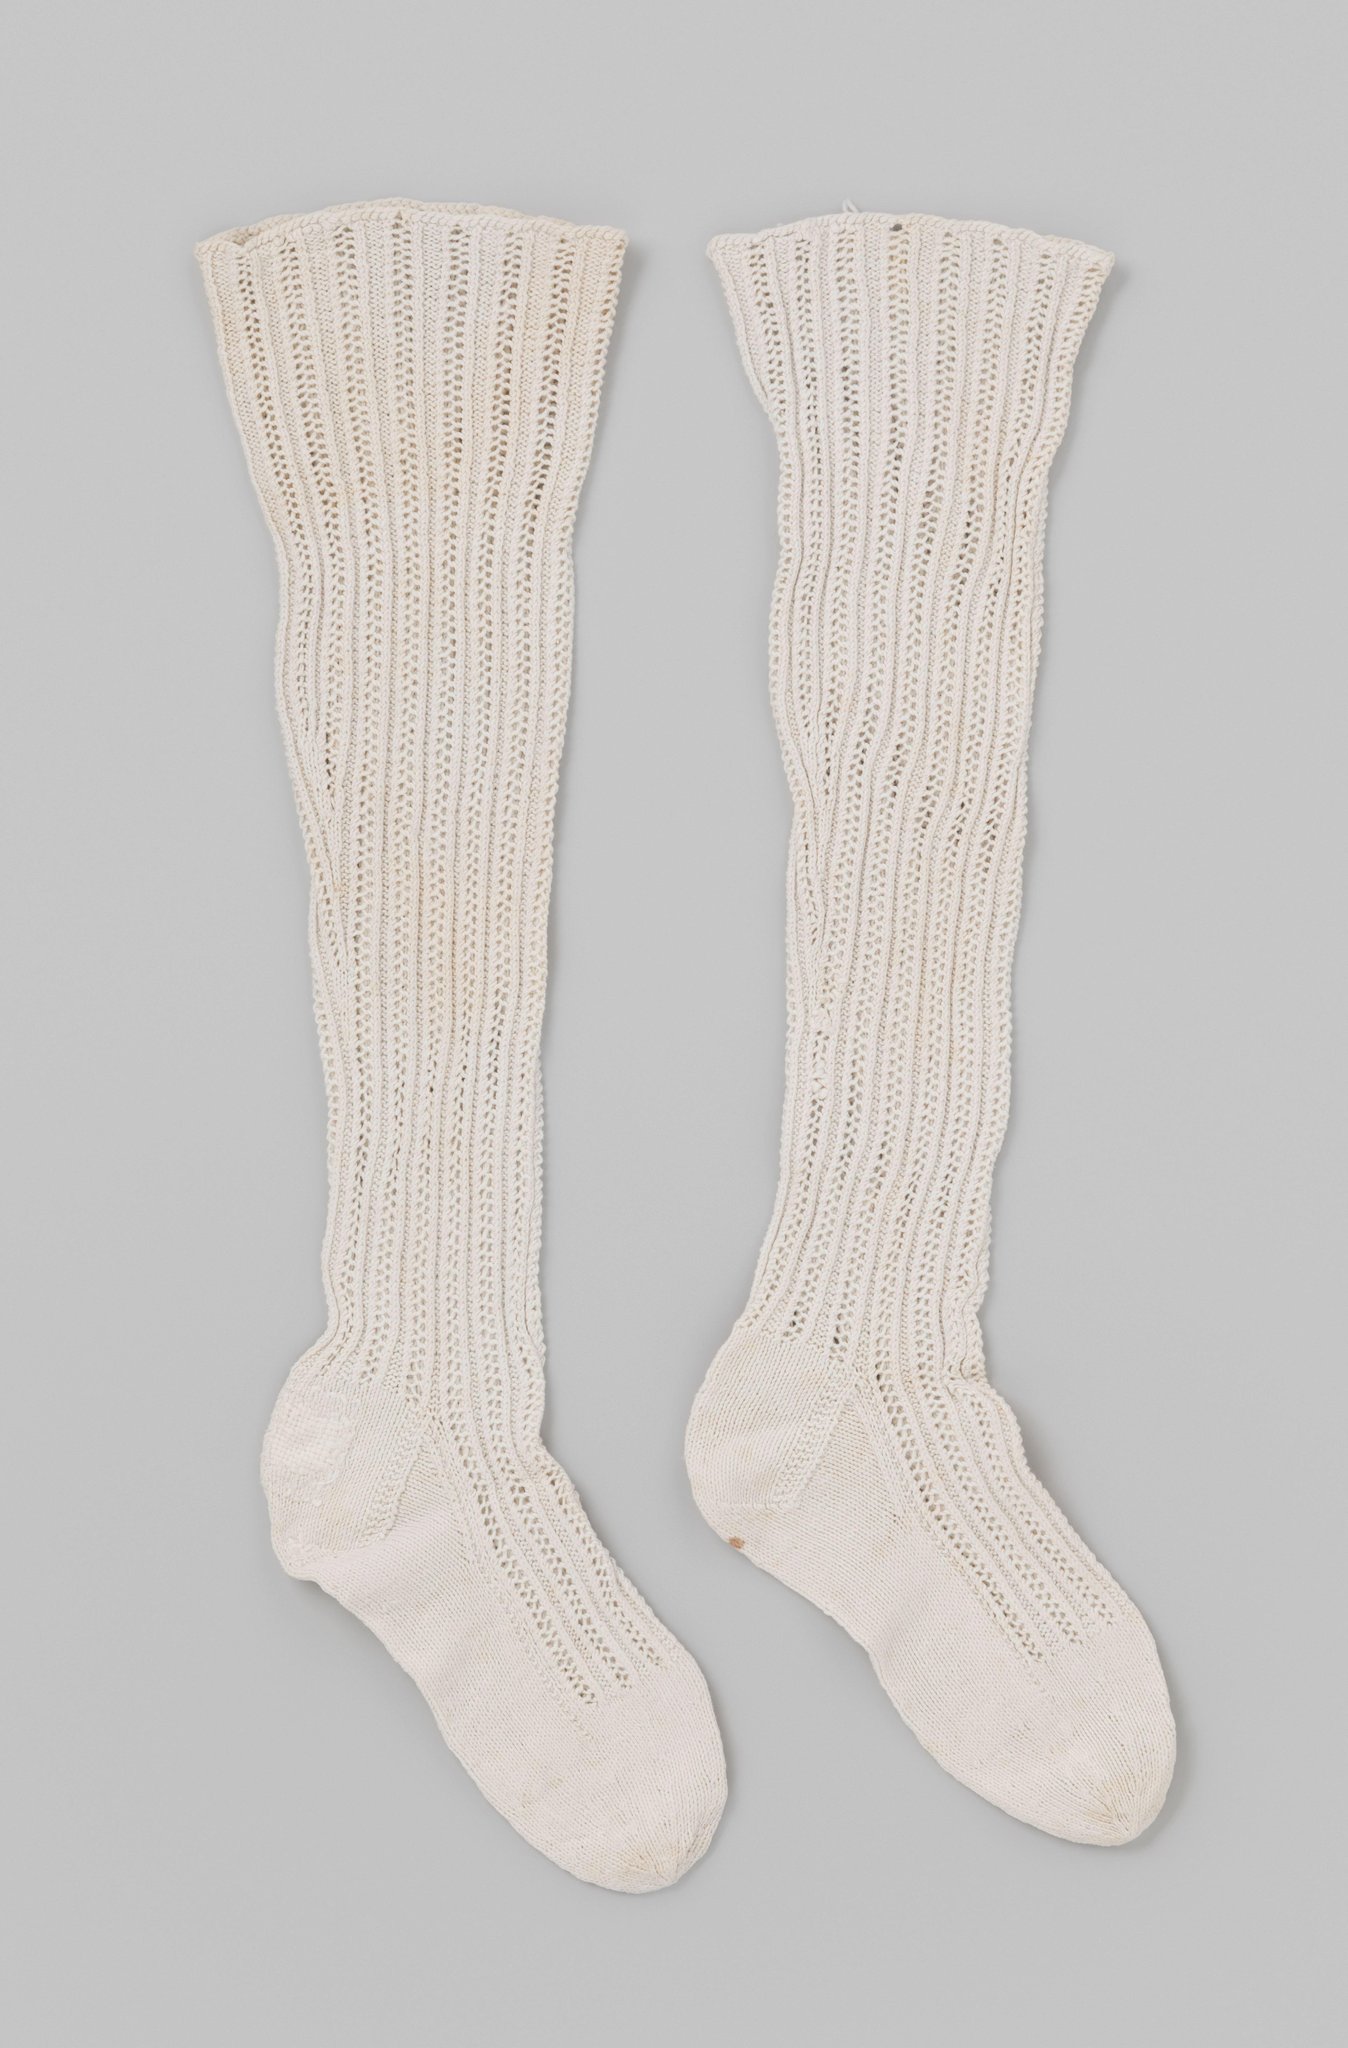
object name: stocking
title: Kous van witte katoenen tricot, met, op de voet na, een ajour patroon in verticale banen, zonder boord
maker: Anonymous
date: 1830-1840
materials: cotton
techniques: embroidery, knitting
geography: netherlands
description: Kous van dikke witte katoenen tricot, met, op de voet na, een ajour patroon in verticale banen, zonder boord.